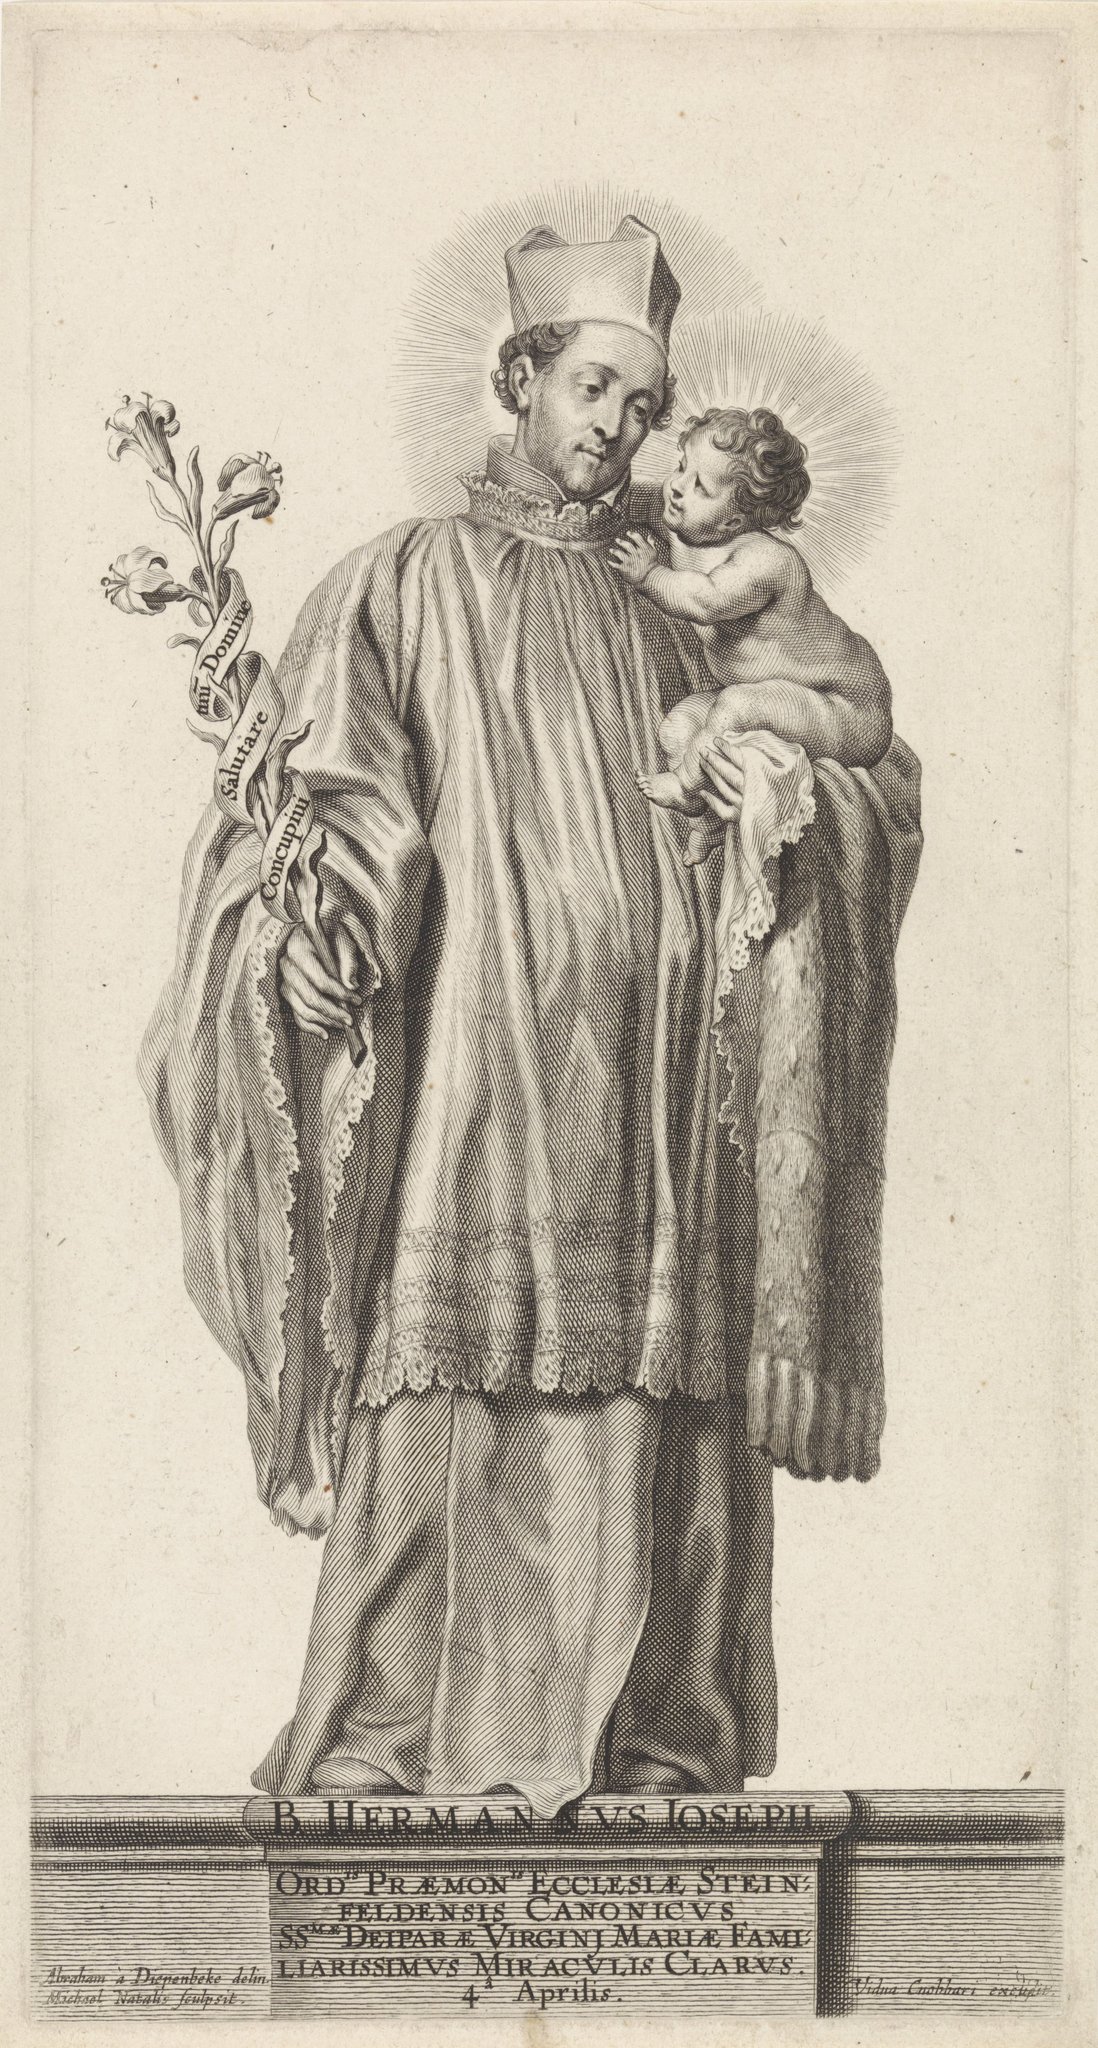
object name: print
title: De heilige Hermanus Josephus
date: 1620-1668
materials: paper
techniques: engraving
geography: liège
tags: male saints (with name)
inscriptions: collector's mark: Lugt 2228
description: De heilige Hermanus Josephus in premonstratenzer kleding, met het Christuskind op de arm. In zijn andere hand draagt hij een lelie. Onderaan op het pedestal een vijfregelige tekst in het Latijn. Prent uit een serie van heiligen.